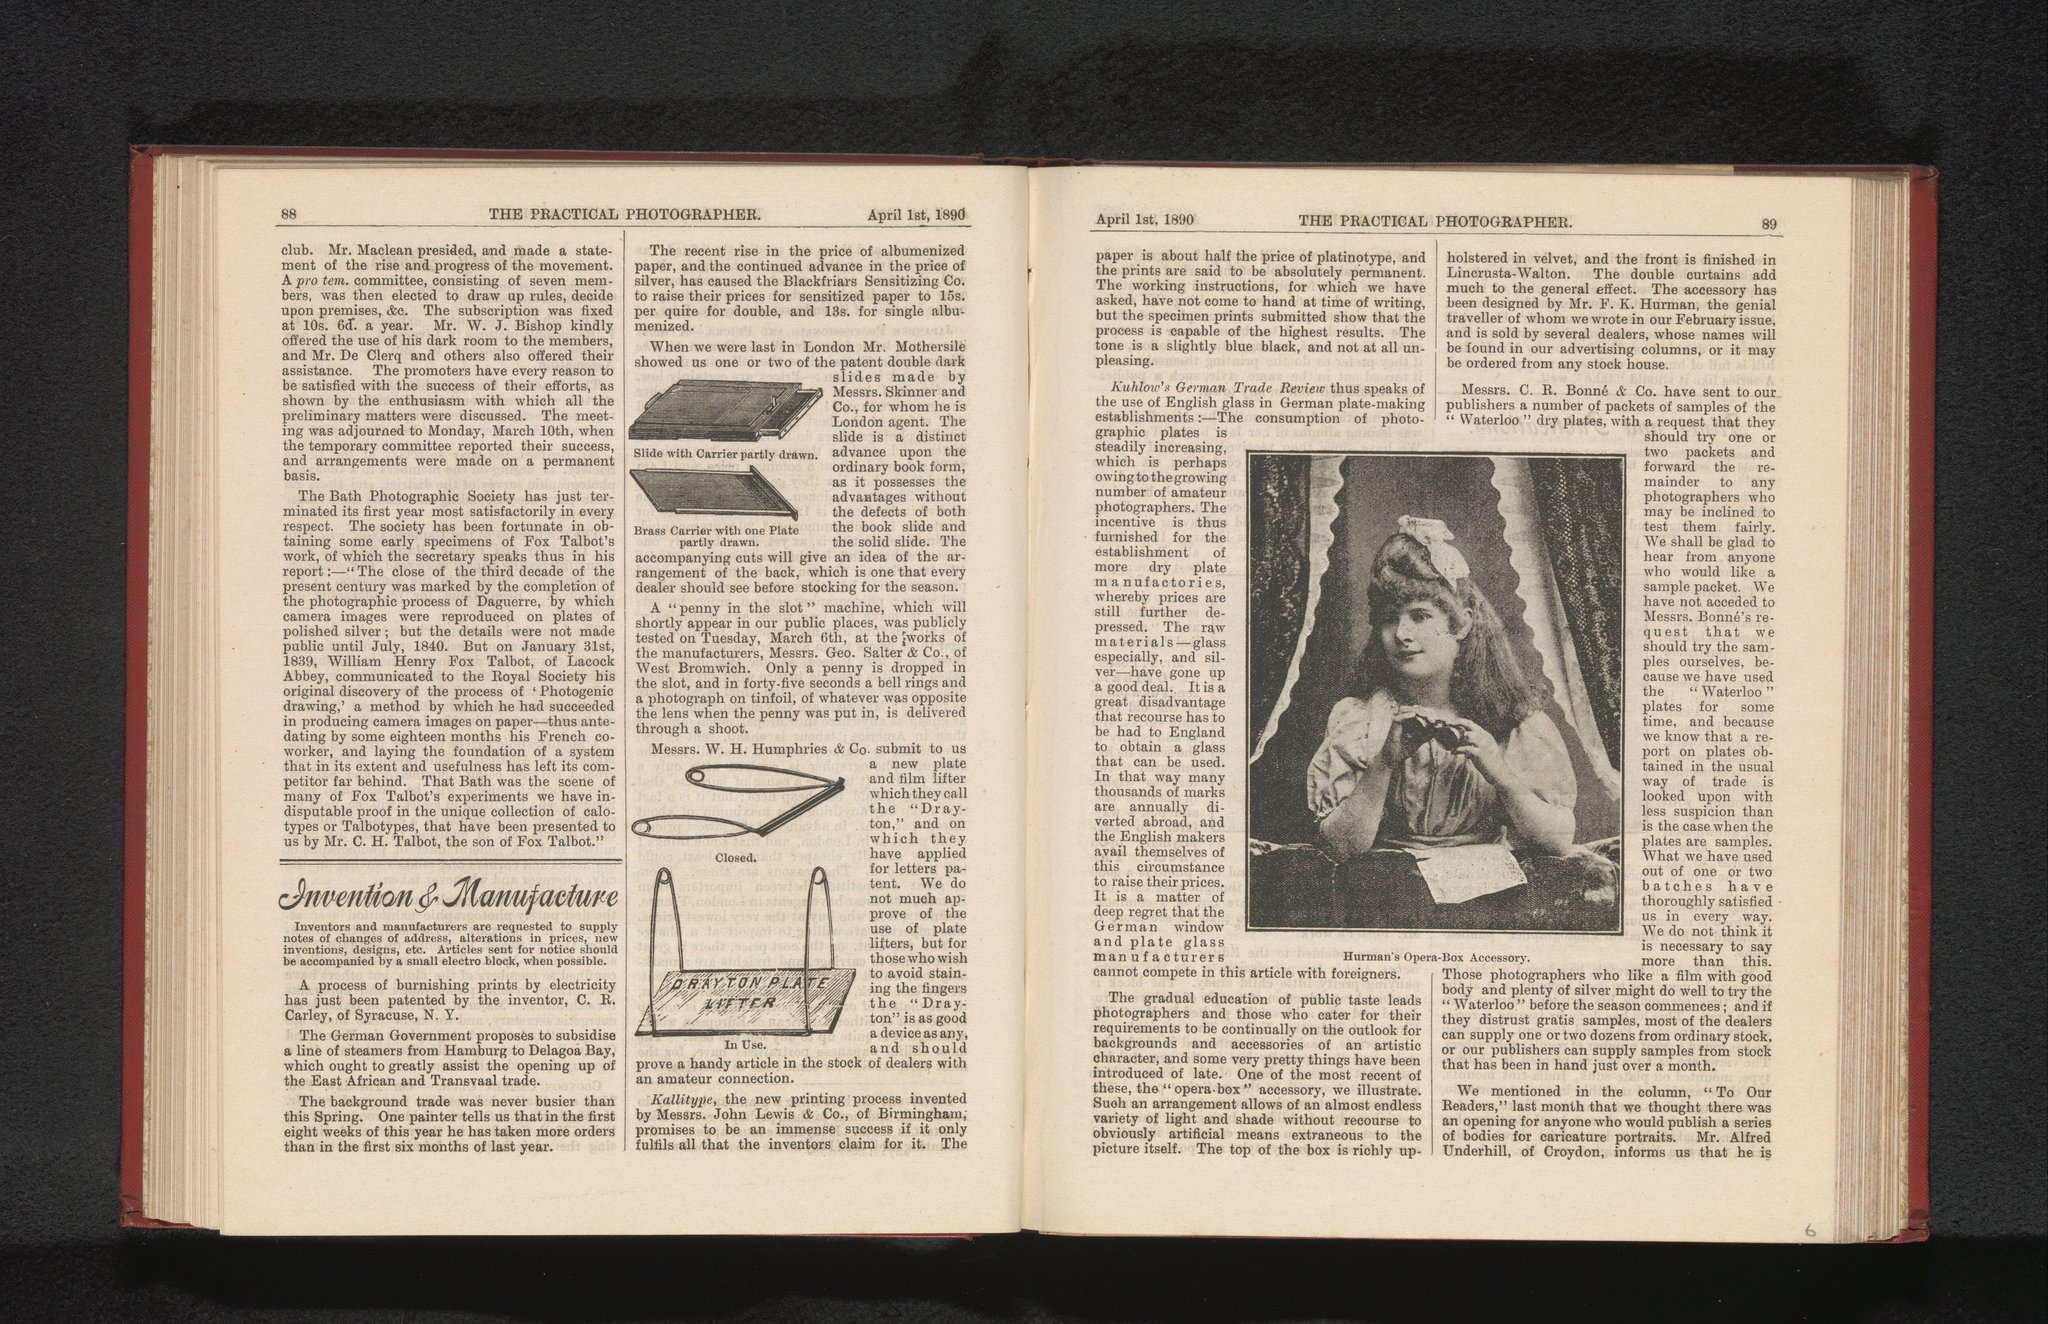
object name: page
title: Hurman's Opera-Box Accessory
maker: Anonymous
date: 1885-1890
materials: paper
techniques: autotype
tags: adolescent, young woman, maiden, binoculars, spy-glass, etc.